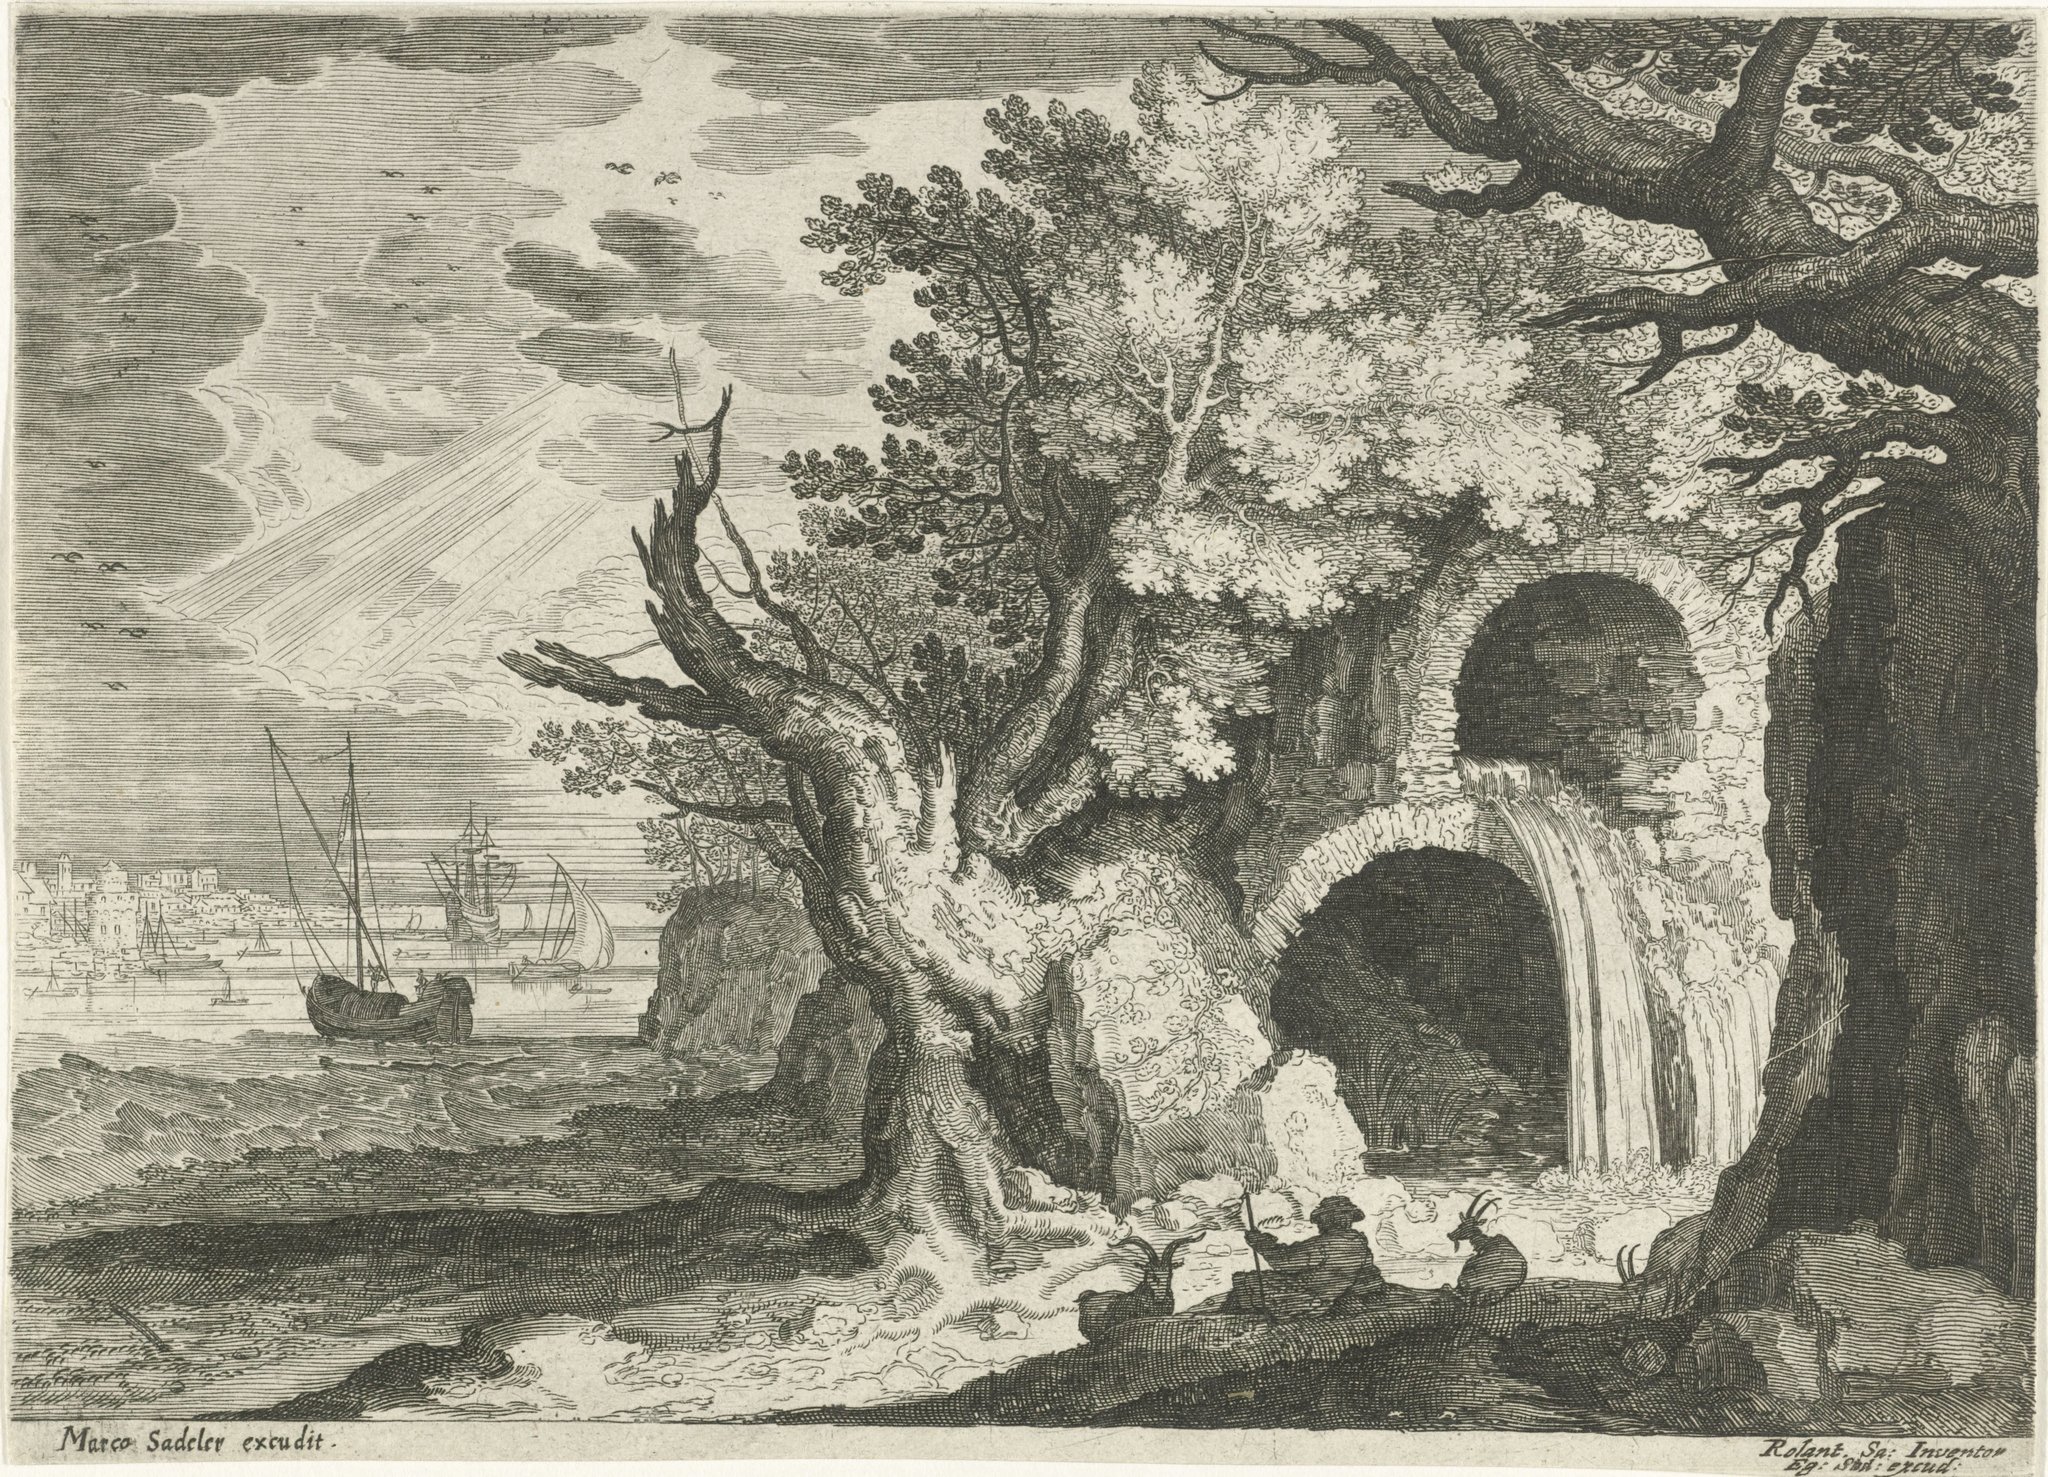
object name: print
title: Landschappen uit Tirol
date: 1580-1629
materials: paper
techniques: engraving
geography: prague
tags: hunting dogs, hunter, waterfall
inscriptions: collector's mark: Lugt 240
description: Rechts een begroeid aquaduct met waterval. Op de voorgrond een herder met twee geiten. Links water met zeilbootjes en heuvels in verschiet. De derde prent van een zesdelige reeks met landschappen uit Tirol.